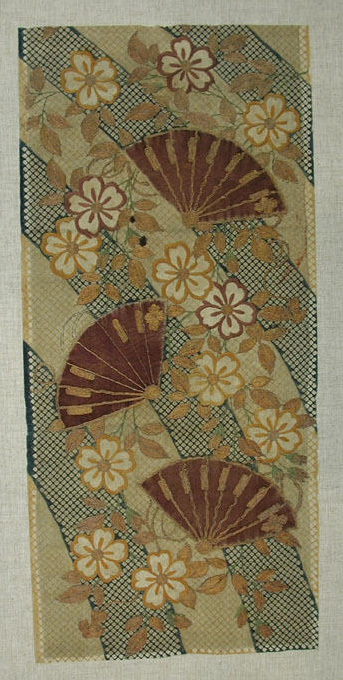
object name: piece from a kosode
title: Piece from a Kosode with Fans and Cherry Blossoms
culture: japanese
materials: metal thread, silk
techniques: damask, dyeing, embroidery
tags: flowers